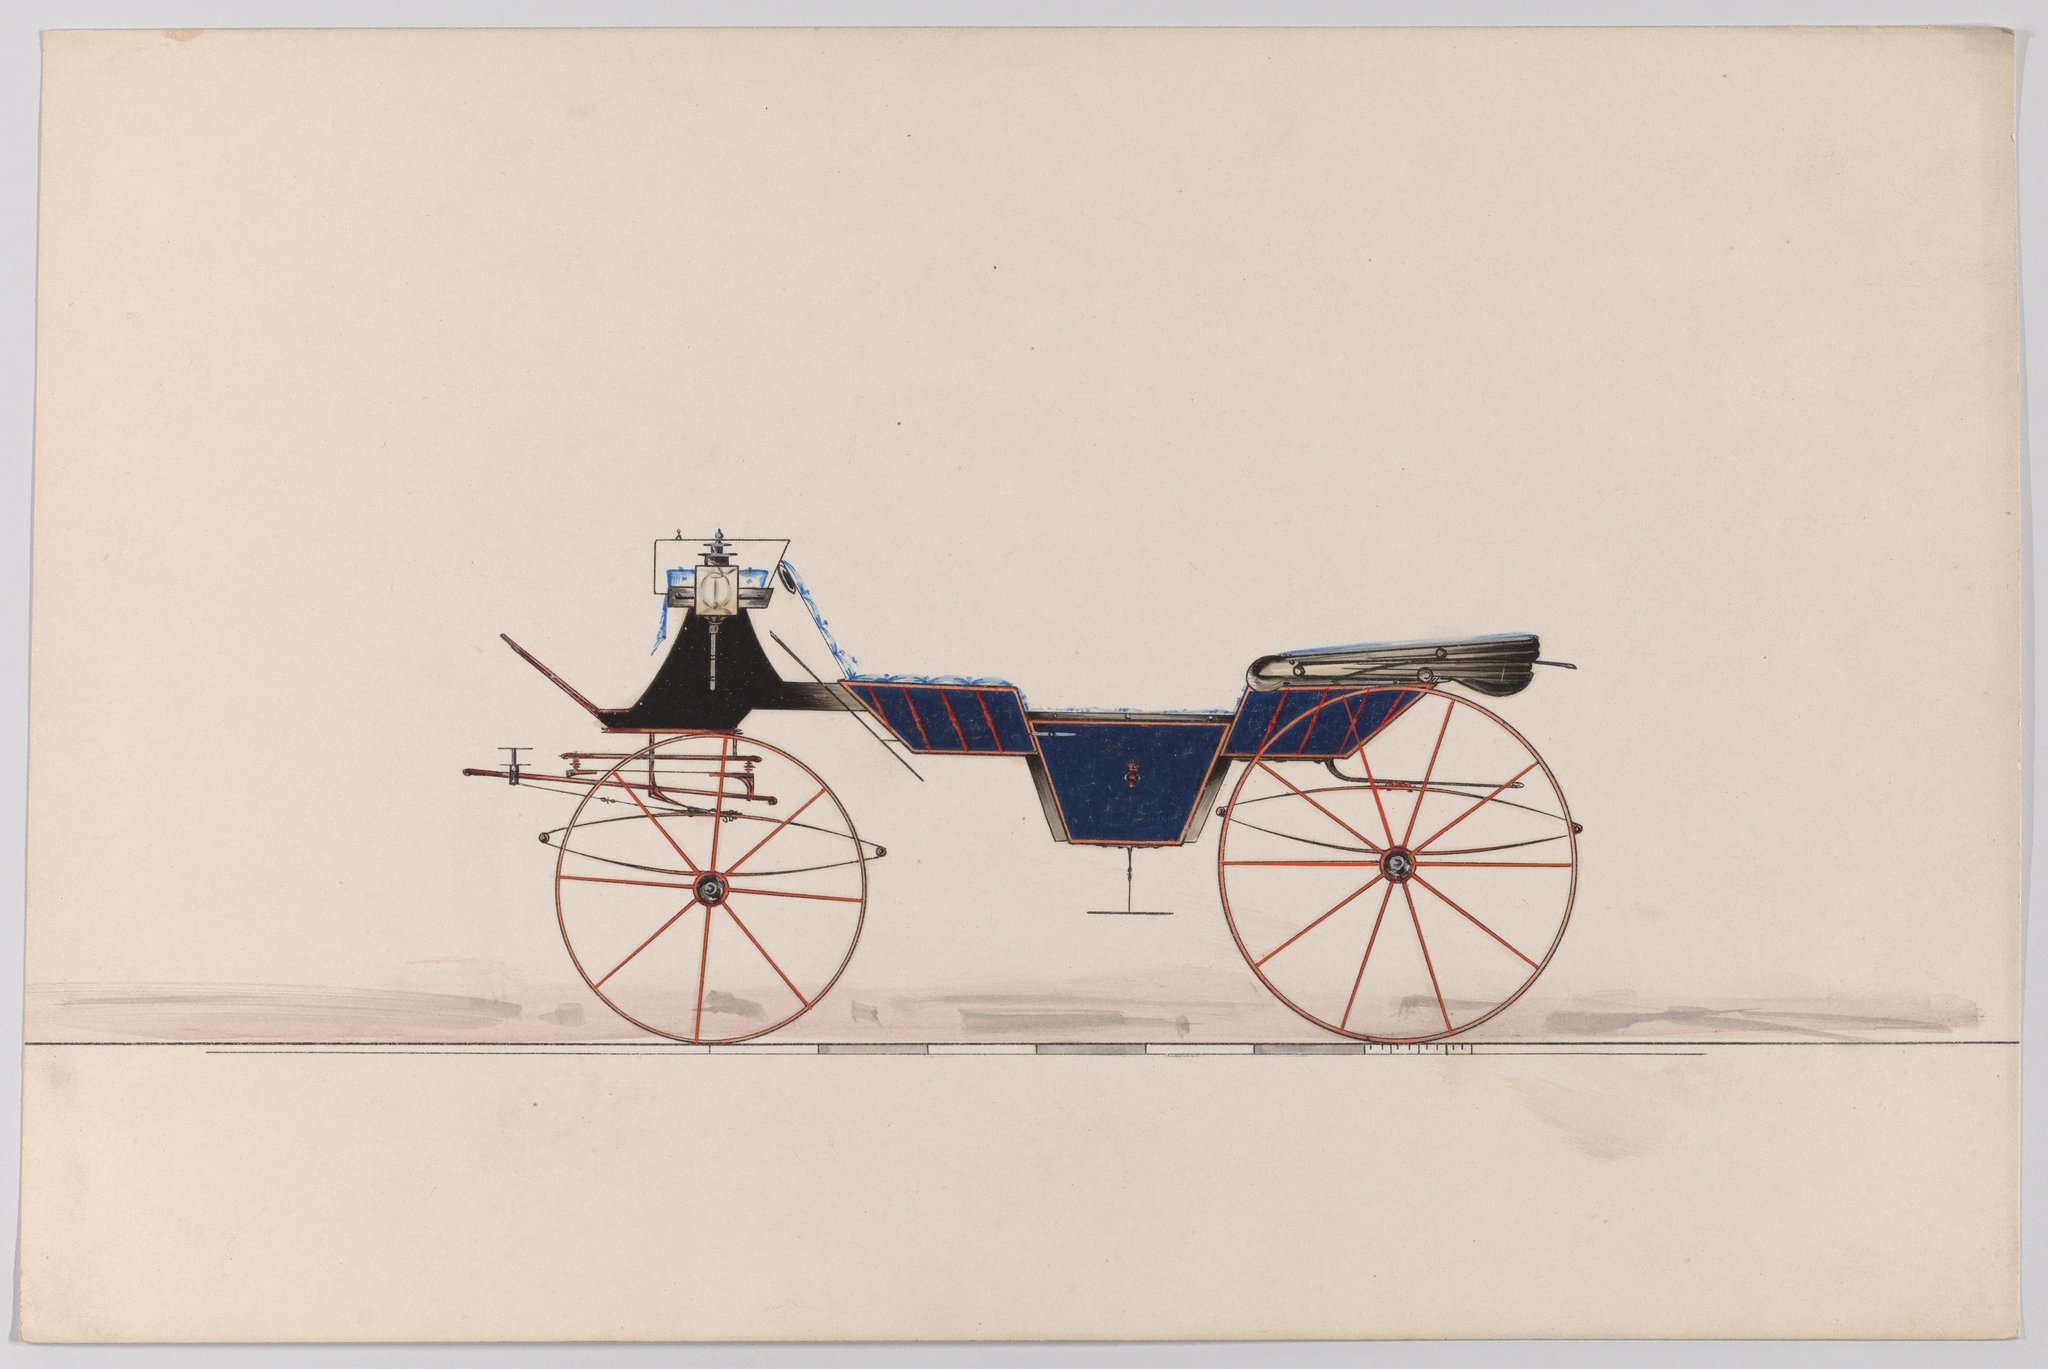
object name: drawing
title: Design for Drop Center Vis-à-vis (unnumbered)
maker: brewster & co.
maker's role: manufacturer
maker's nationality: american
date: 1870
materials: gouache, graphite, gum arabic, ink, watercolor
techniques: pen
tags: carriages